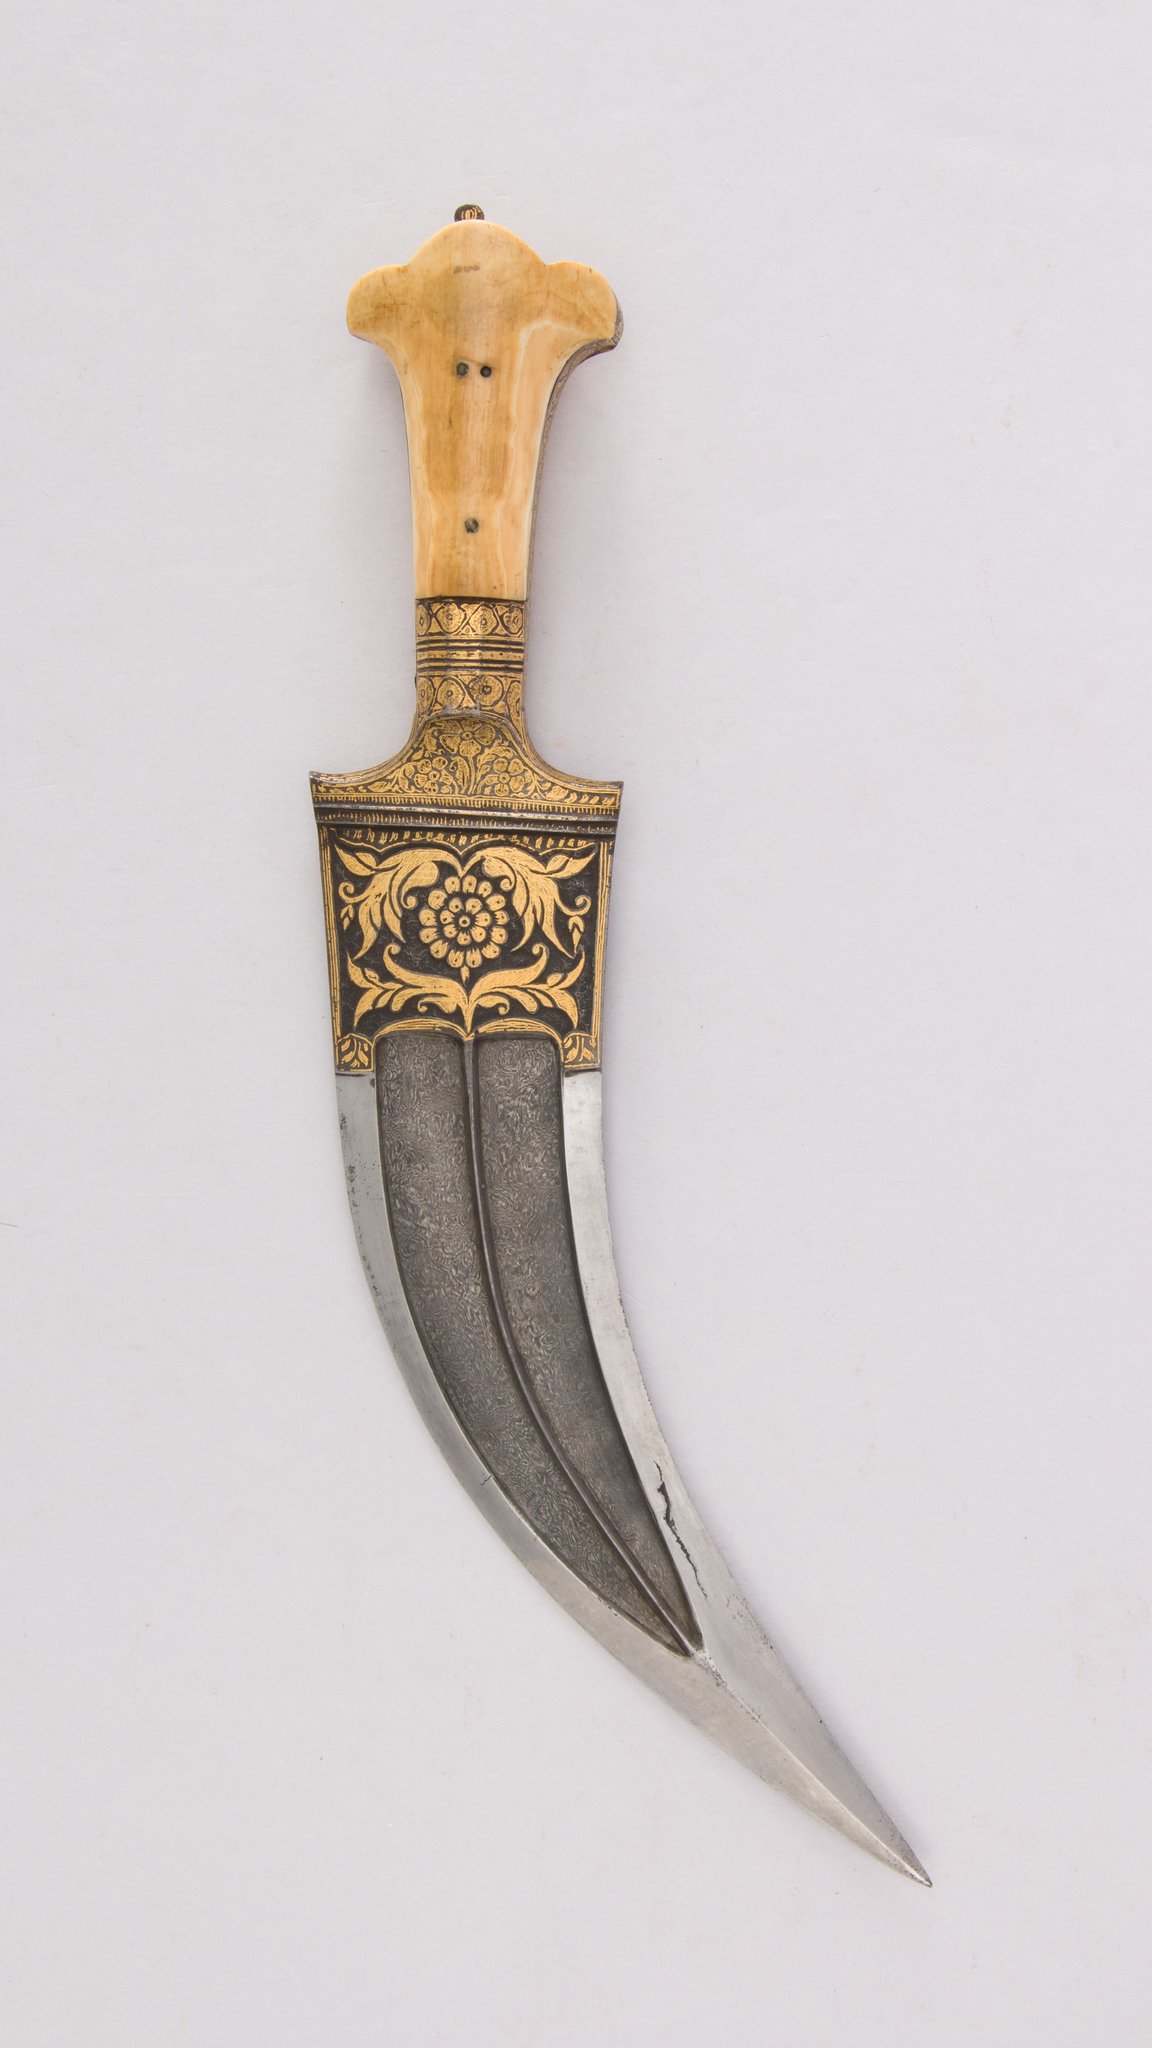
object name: dagger jambiya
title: Dagger (Jambiya)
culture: indian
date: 1701-1900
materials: gold, ivory, steel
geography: india